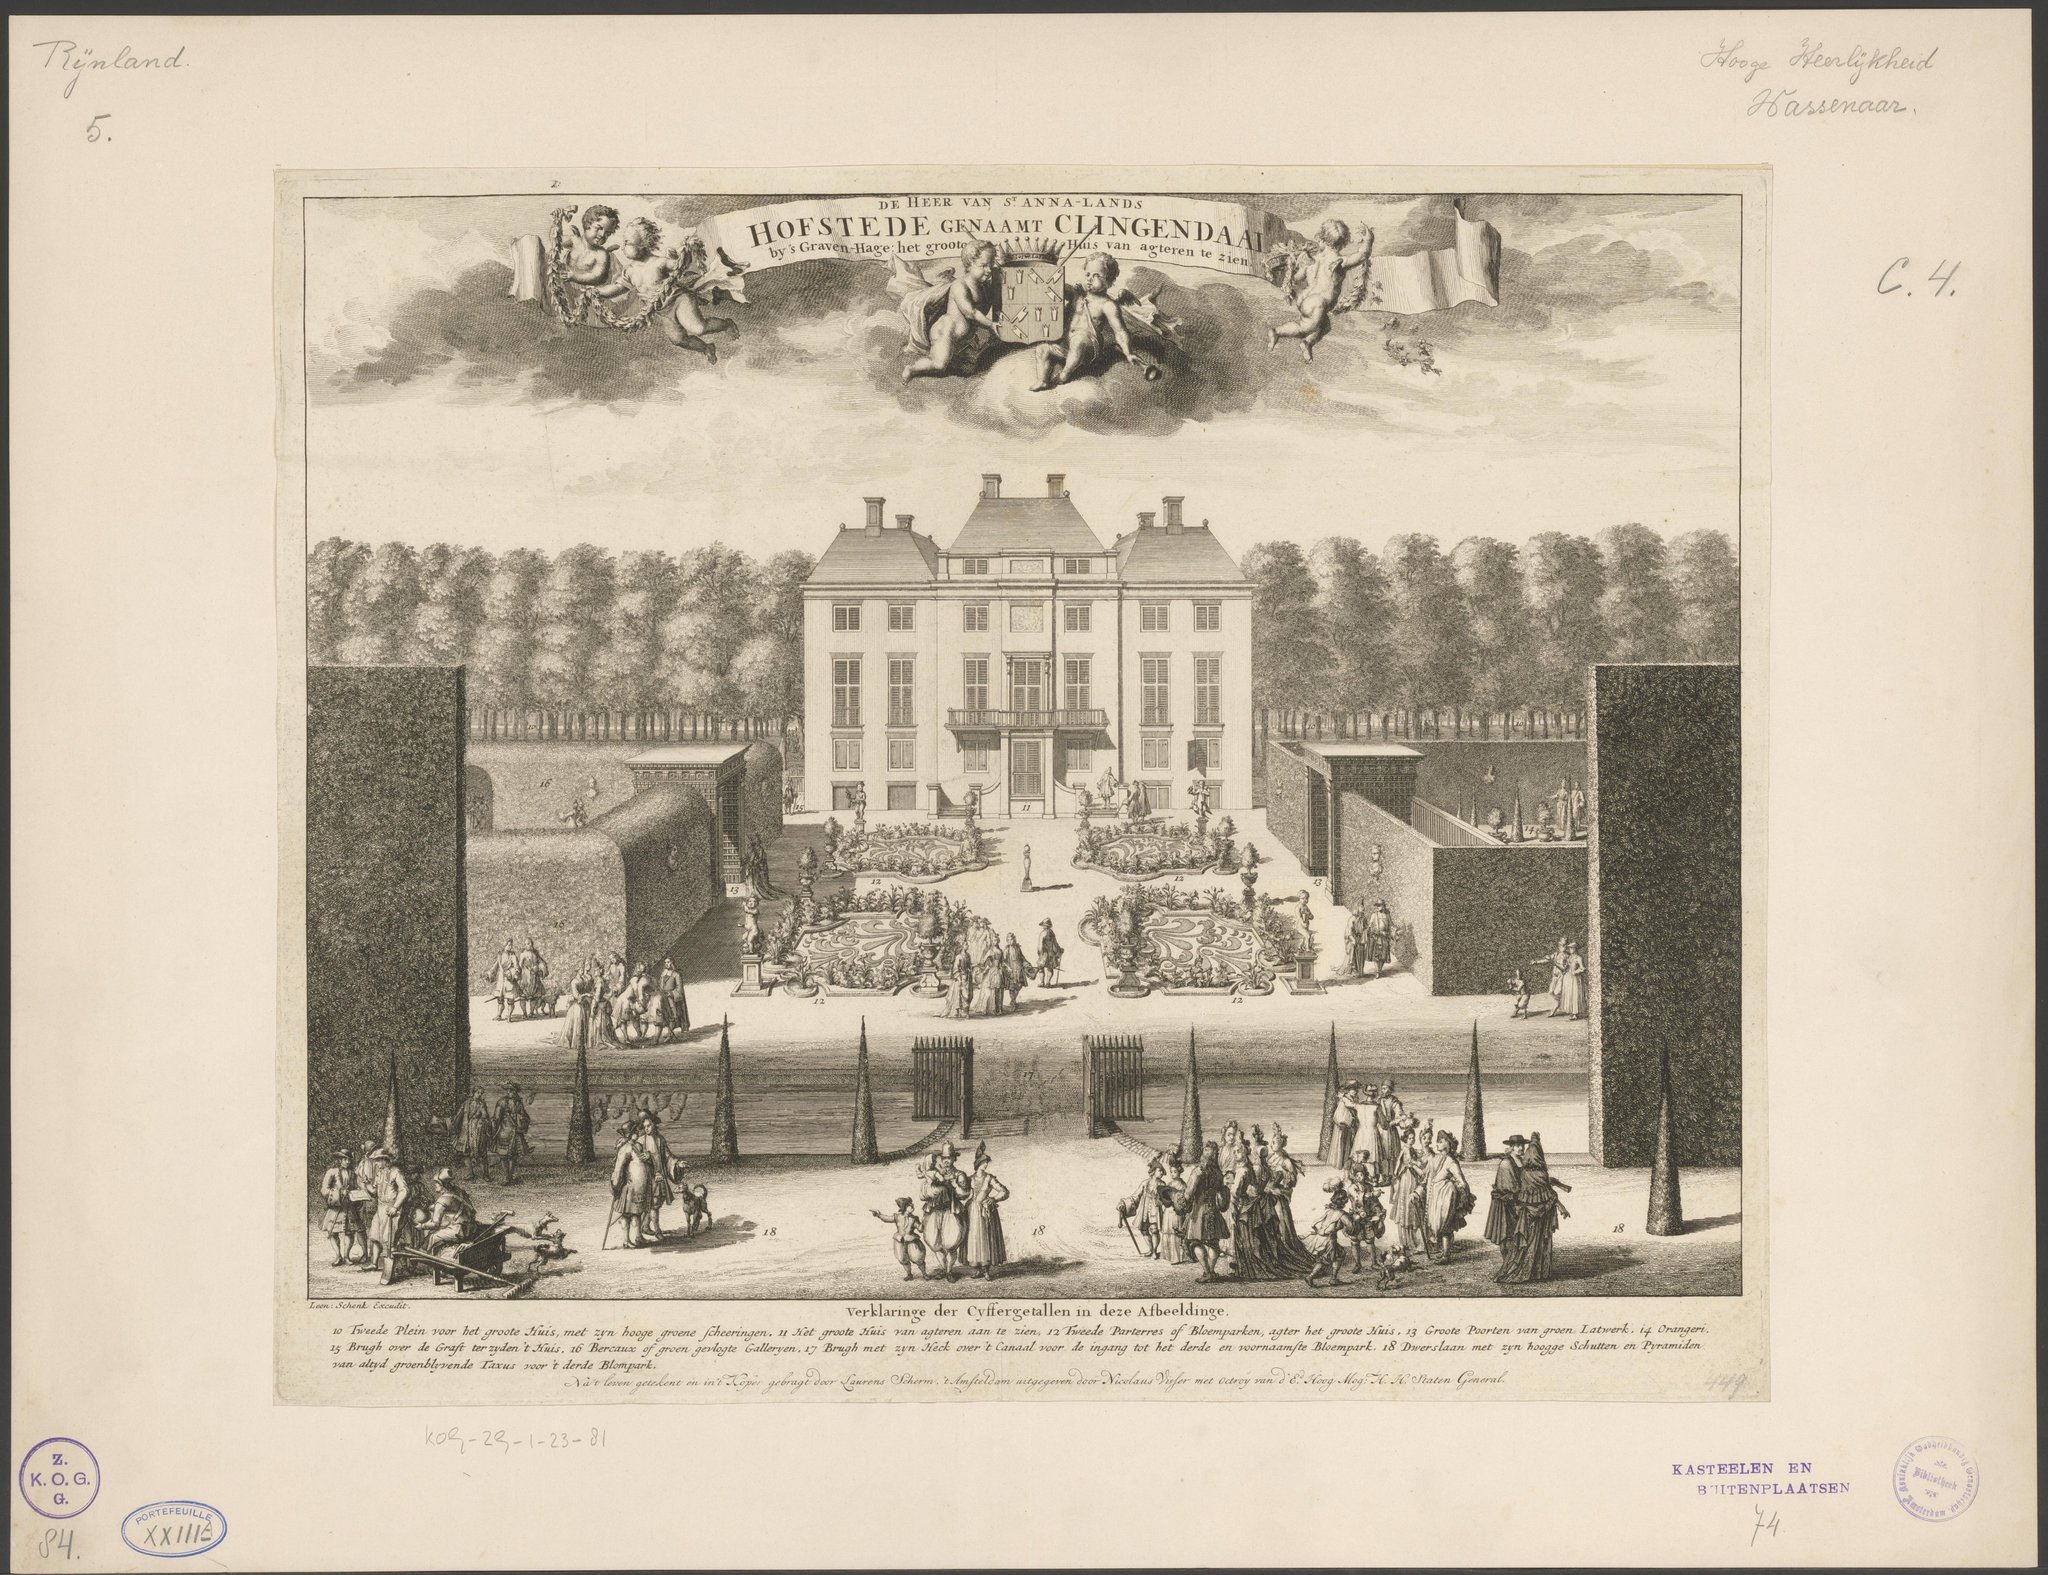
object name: print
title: De Heer van St. Anna-Lands Hofstede genaamt Clingendaal by 's Graven-Hage: het groote Huis van agteren te zien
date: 1710-1767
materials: paper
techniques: engraving, etching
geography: amsterdam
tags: french or architectonic garden; formal garden, bird's eye view ~ representation of building, cupids: 'amores', 'amoretti', 'putti', armorial bearing, heraldry, country-house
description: Gezicht op landhuis Clingendael in vogelvlucht. Midden boven een door putti geflankeerde wimpel en het wapenschild van de familie Doublet(h). Onder in de marge de legenda 1-18. Onderwerpsrubrieken binnen de Atlas Zeden en Gewoonten: Zeden en Gewoonten in Engeren Zin, De Woning. Kastelen en buitenplaatsen. Holland.